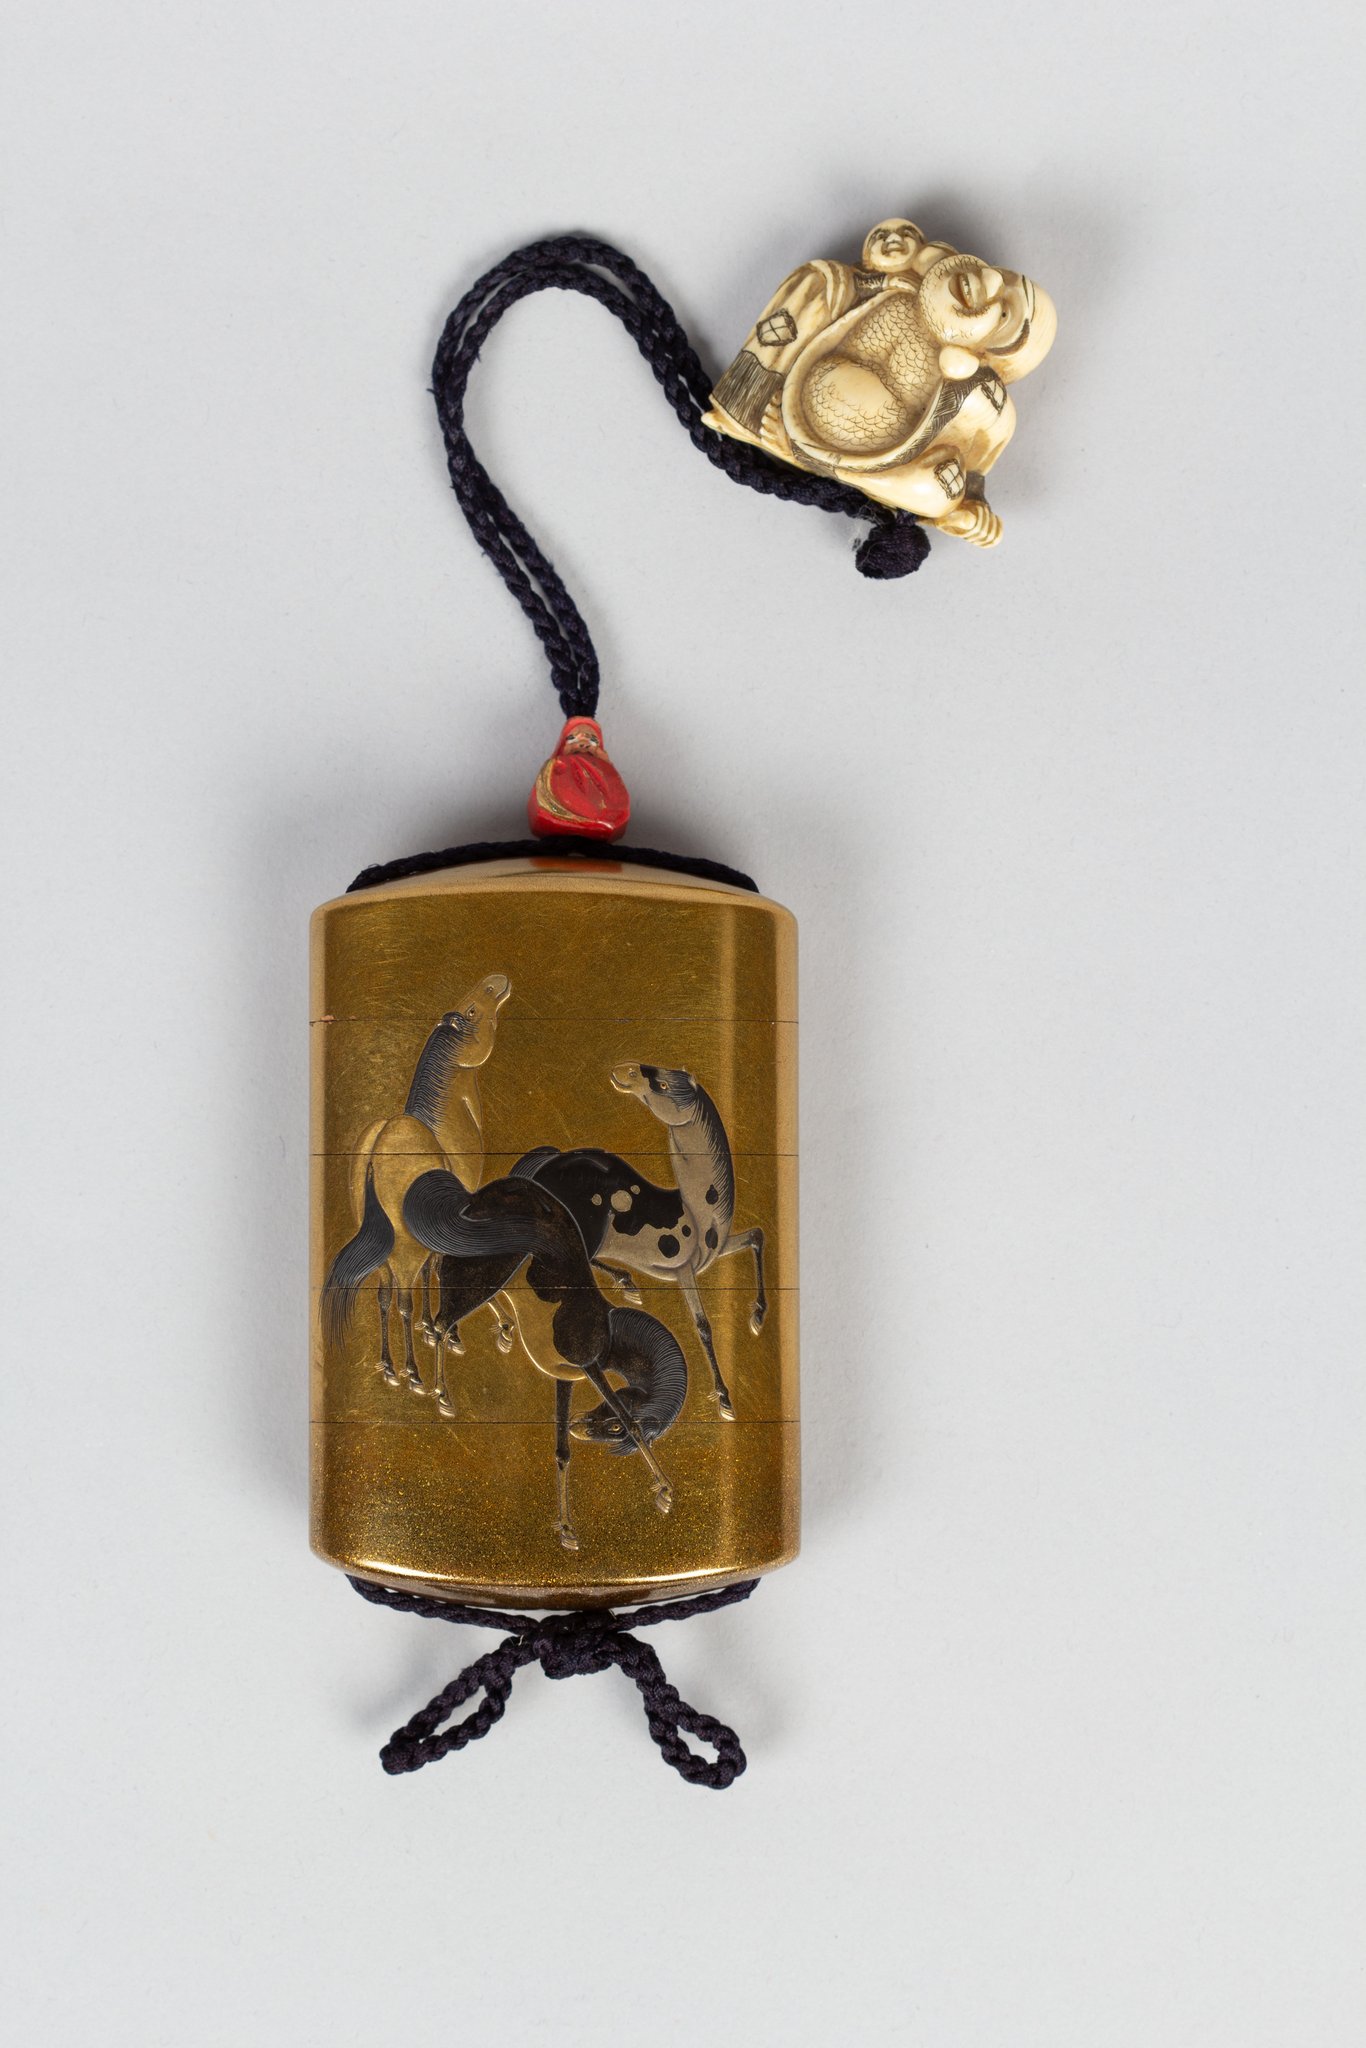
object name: inrō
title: Case (Inrō) with Design of Five Playing Horses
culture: japanese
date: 1801-1900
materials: gold, lacquer, silver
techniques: fundame, hiramakie, maki-e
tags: horses